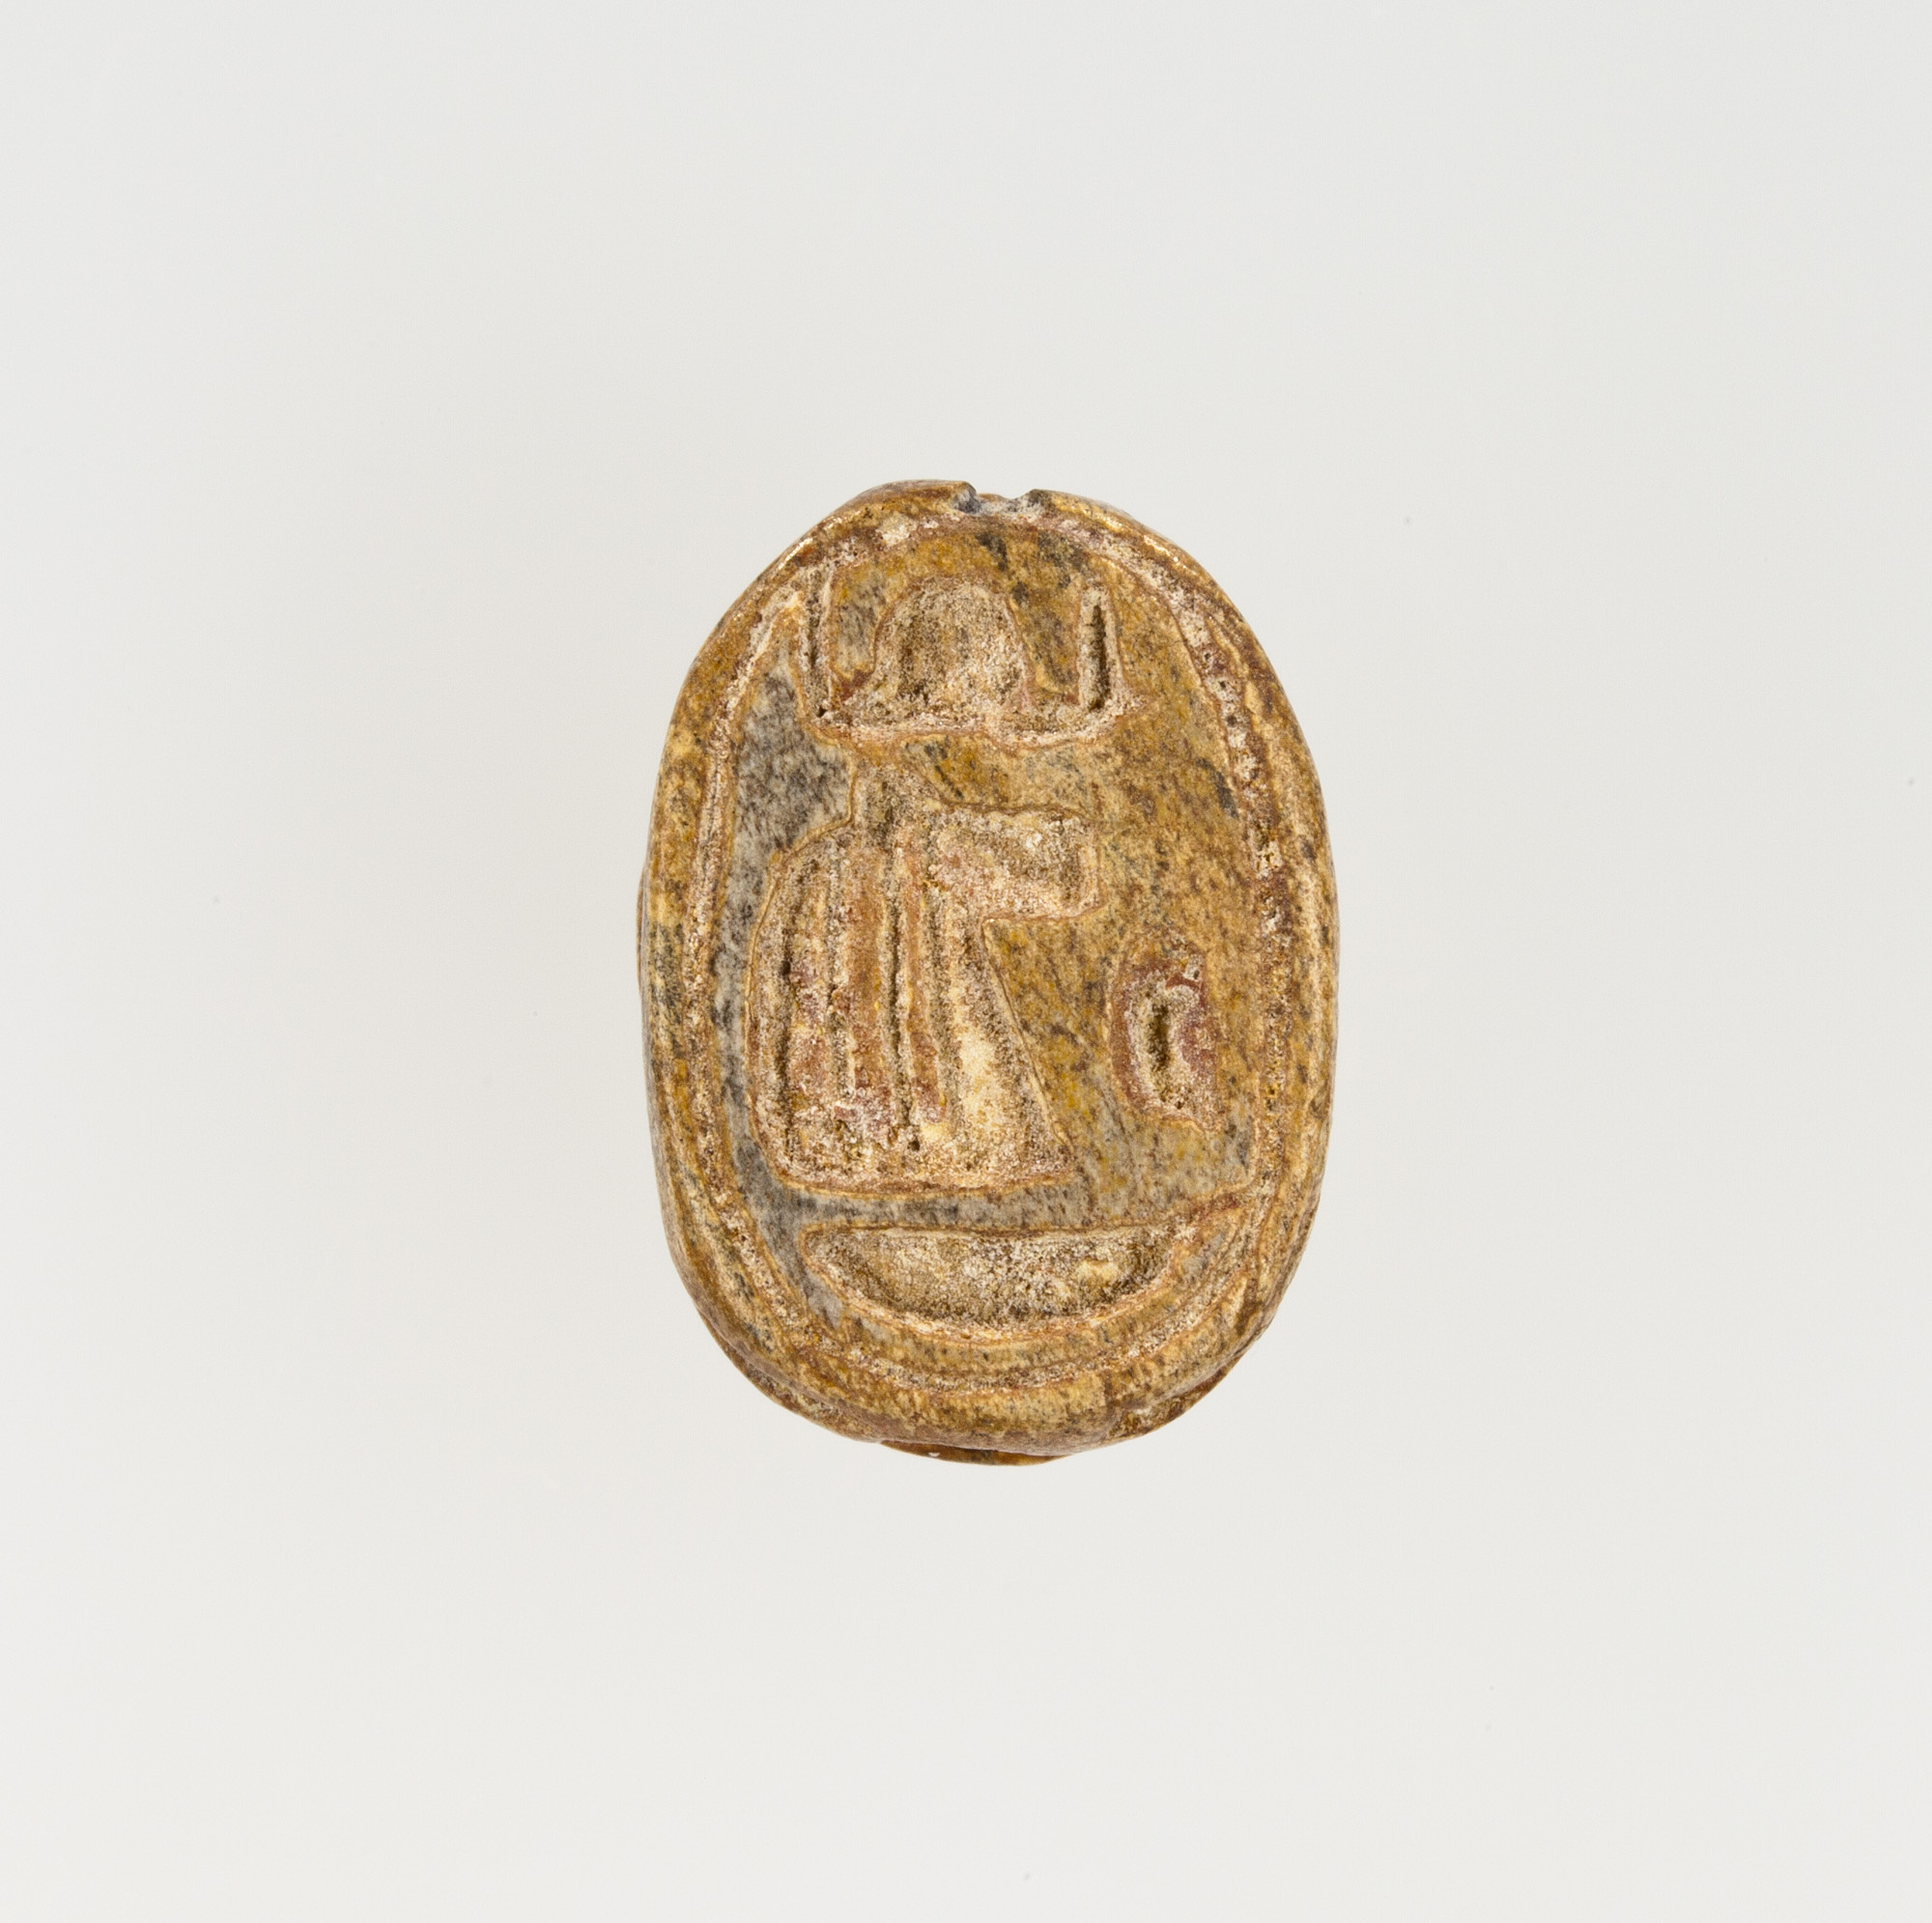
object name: scarab, ahmose, nebpehtyre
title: Scarab Inscribed with the Throne Name of Ahmose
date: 1550-1525 BCE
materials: stone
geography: egypt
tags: scarabs